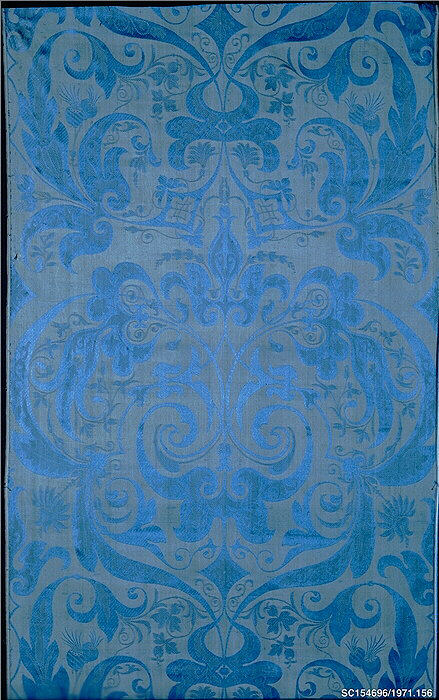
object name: length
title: Length of furnishing fabric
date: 1830-1839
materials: silk